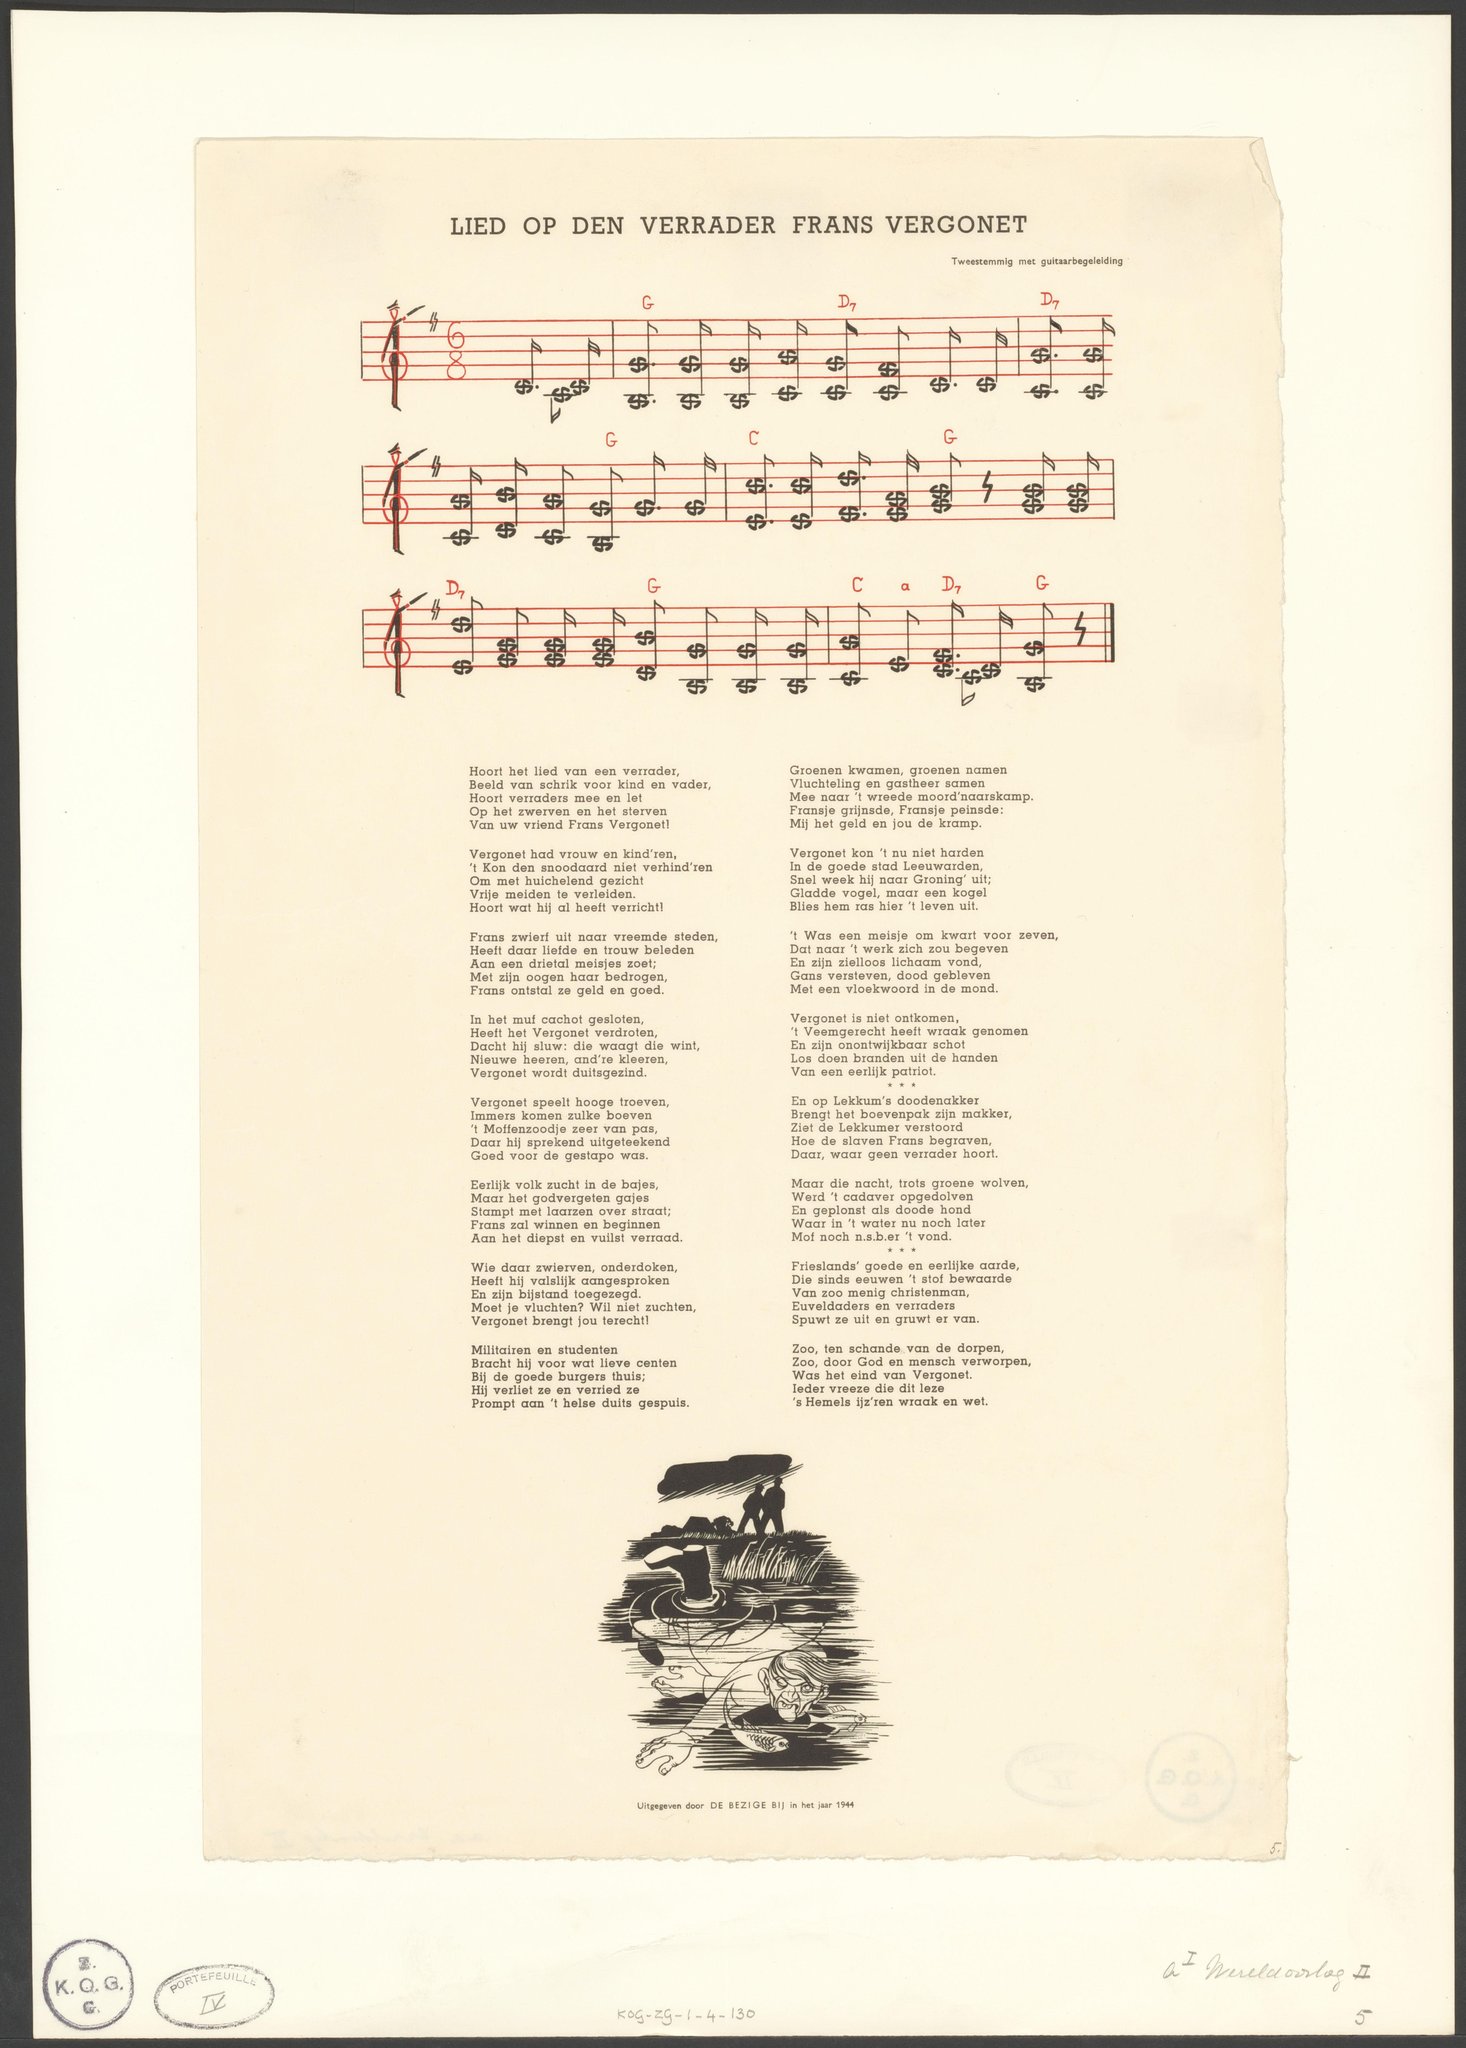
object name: pamphlet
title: Lied op den verrader Frans Vergonet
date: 1906-1944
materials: paper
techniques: linocut, printing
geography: the hague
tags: political propaganda, printed edition of musical score, violent death by firearms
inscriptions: collector's mark: Lugt 1641, collector's mark